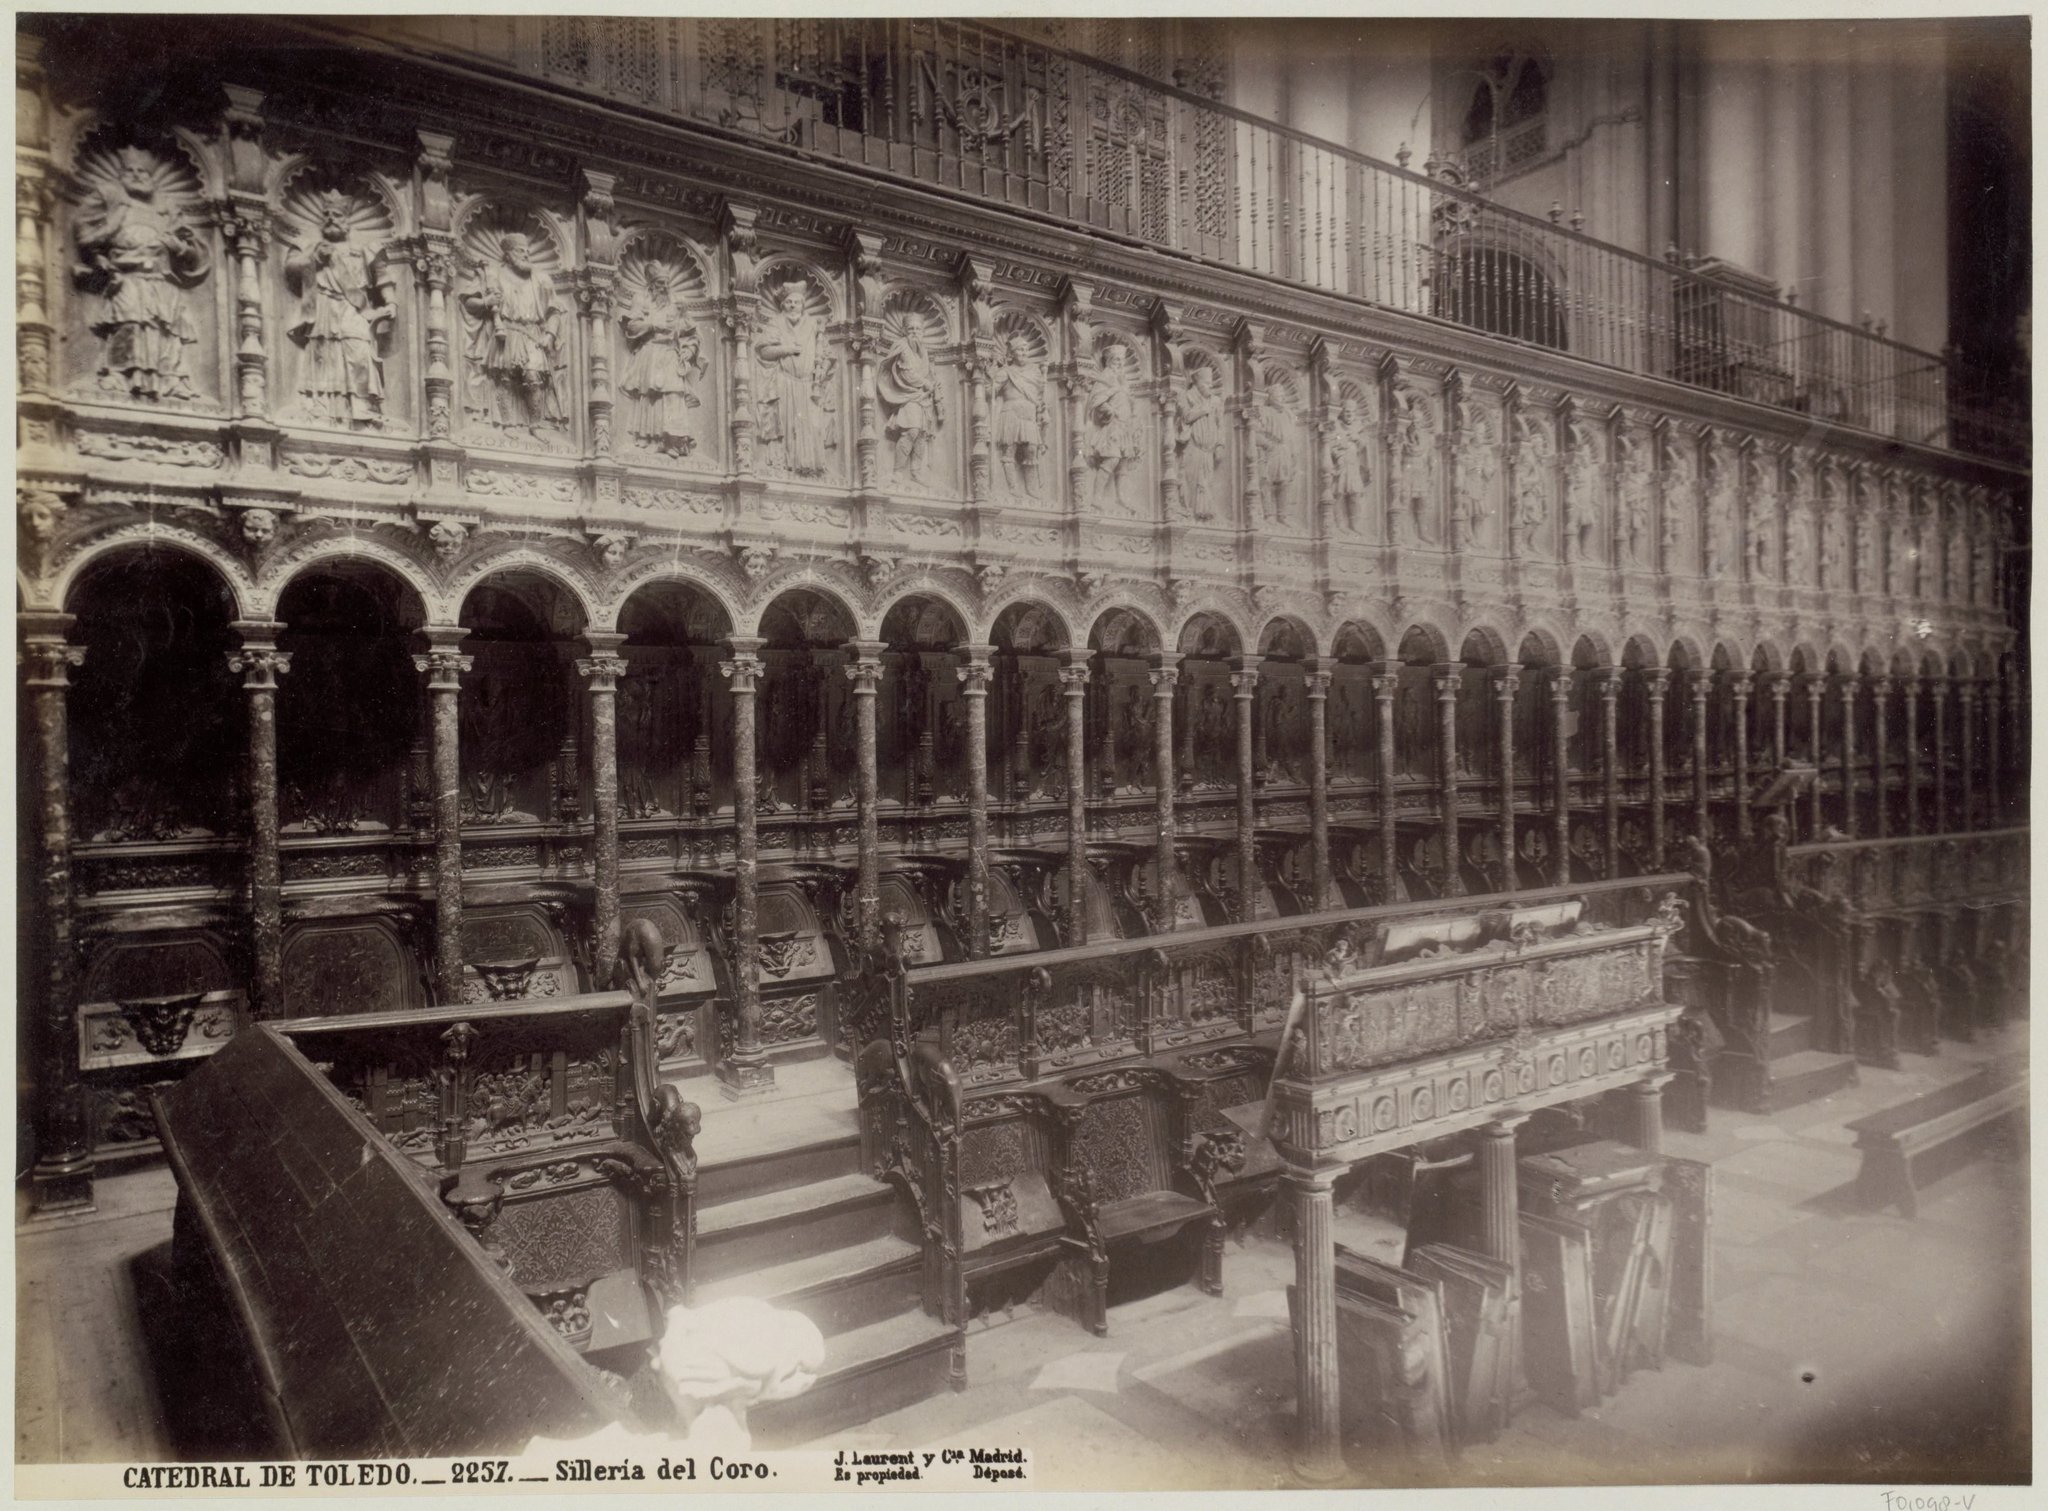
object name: photograph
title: CATEDRAL DE TOLEDO.- Sillería del Coro.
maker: juan laurent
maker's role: publisher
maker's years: 1816-1896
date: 1857-1880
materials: cardboard, paper, photographic support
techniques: albumen print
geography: toledo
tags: seats of the clergy, choir-stalls, parts of church interior: choir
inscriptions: negative number: ‘2257’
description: Onderdeel van Reisalbum met foto's van bezienswaardigheden in Spanje en Marokko.